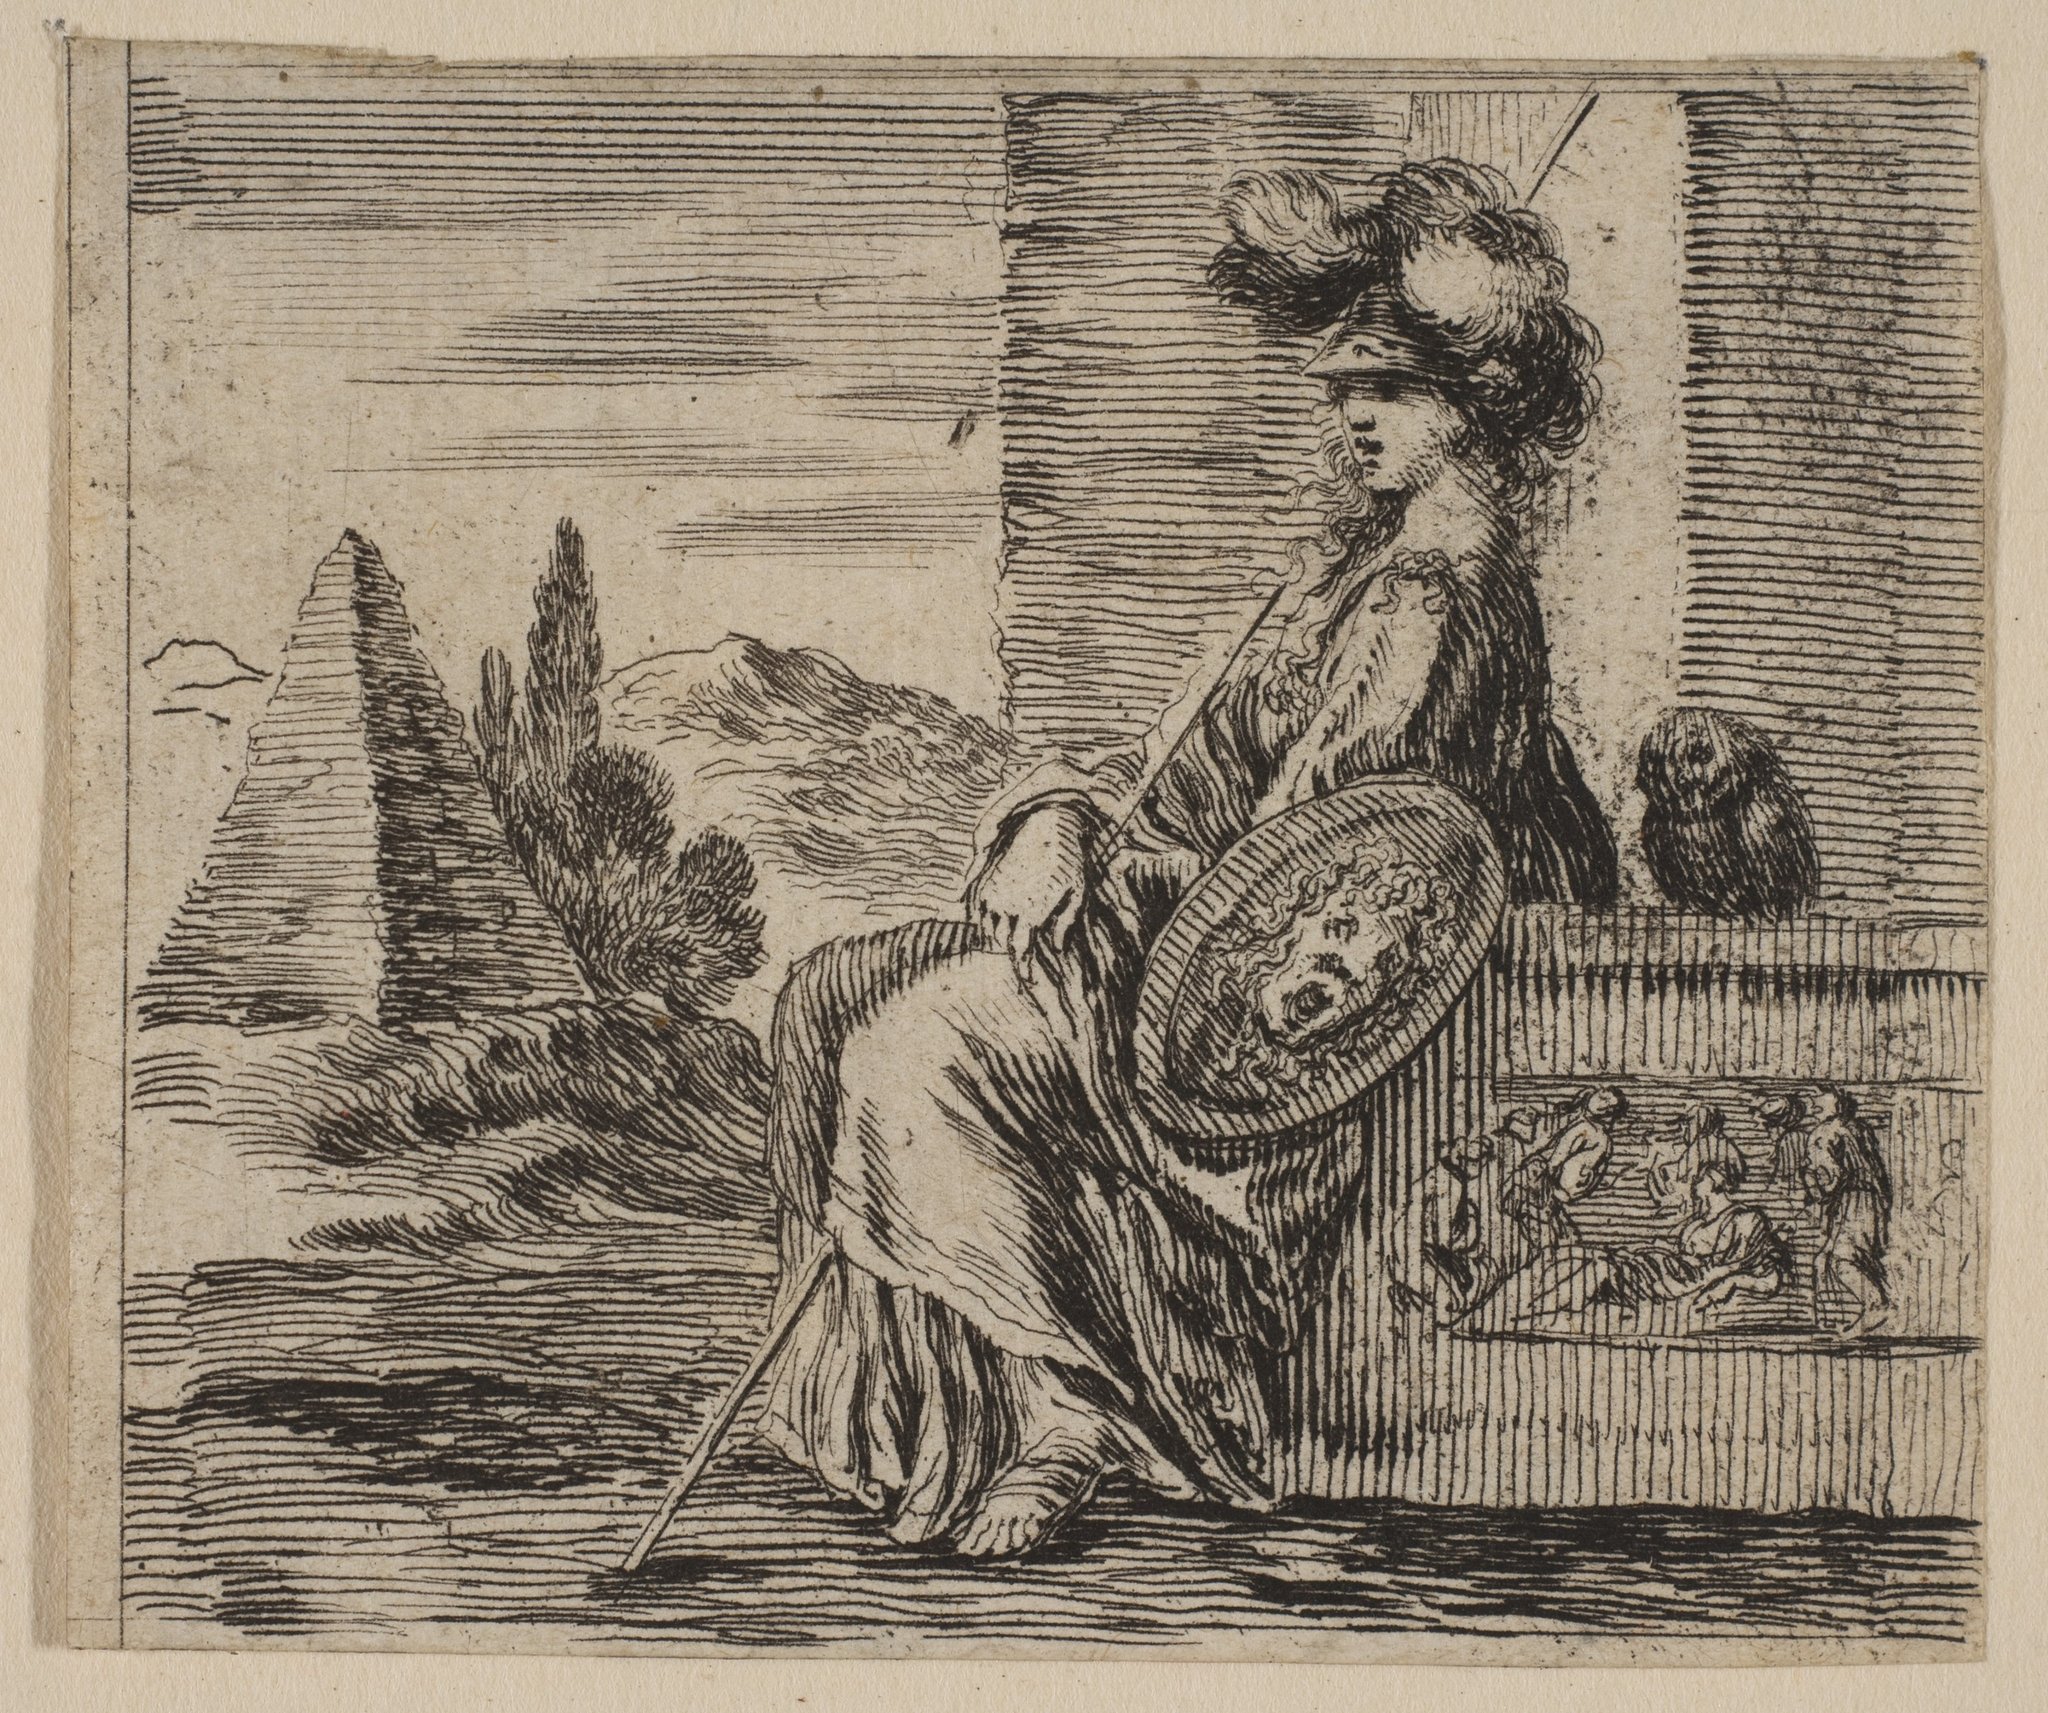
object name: print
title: Pallas, from 'Game of Mythology' (Jeu de la Mythologie)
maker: stefano della bella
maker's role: artist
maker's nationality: italian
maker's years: 1610-1664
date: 1644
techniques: etching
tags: women,owls